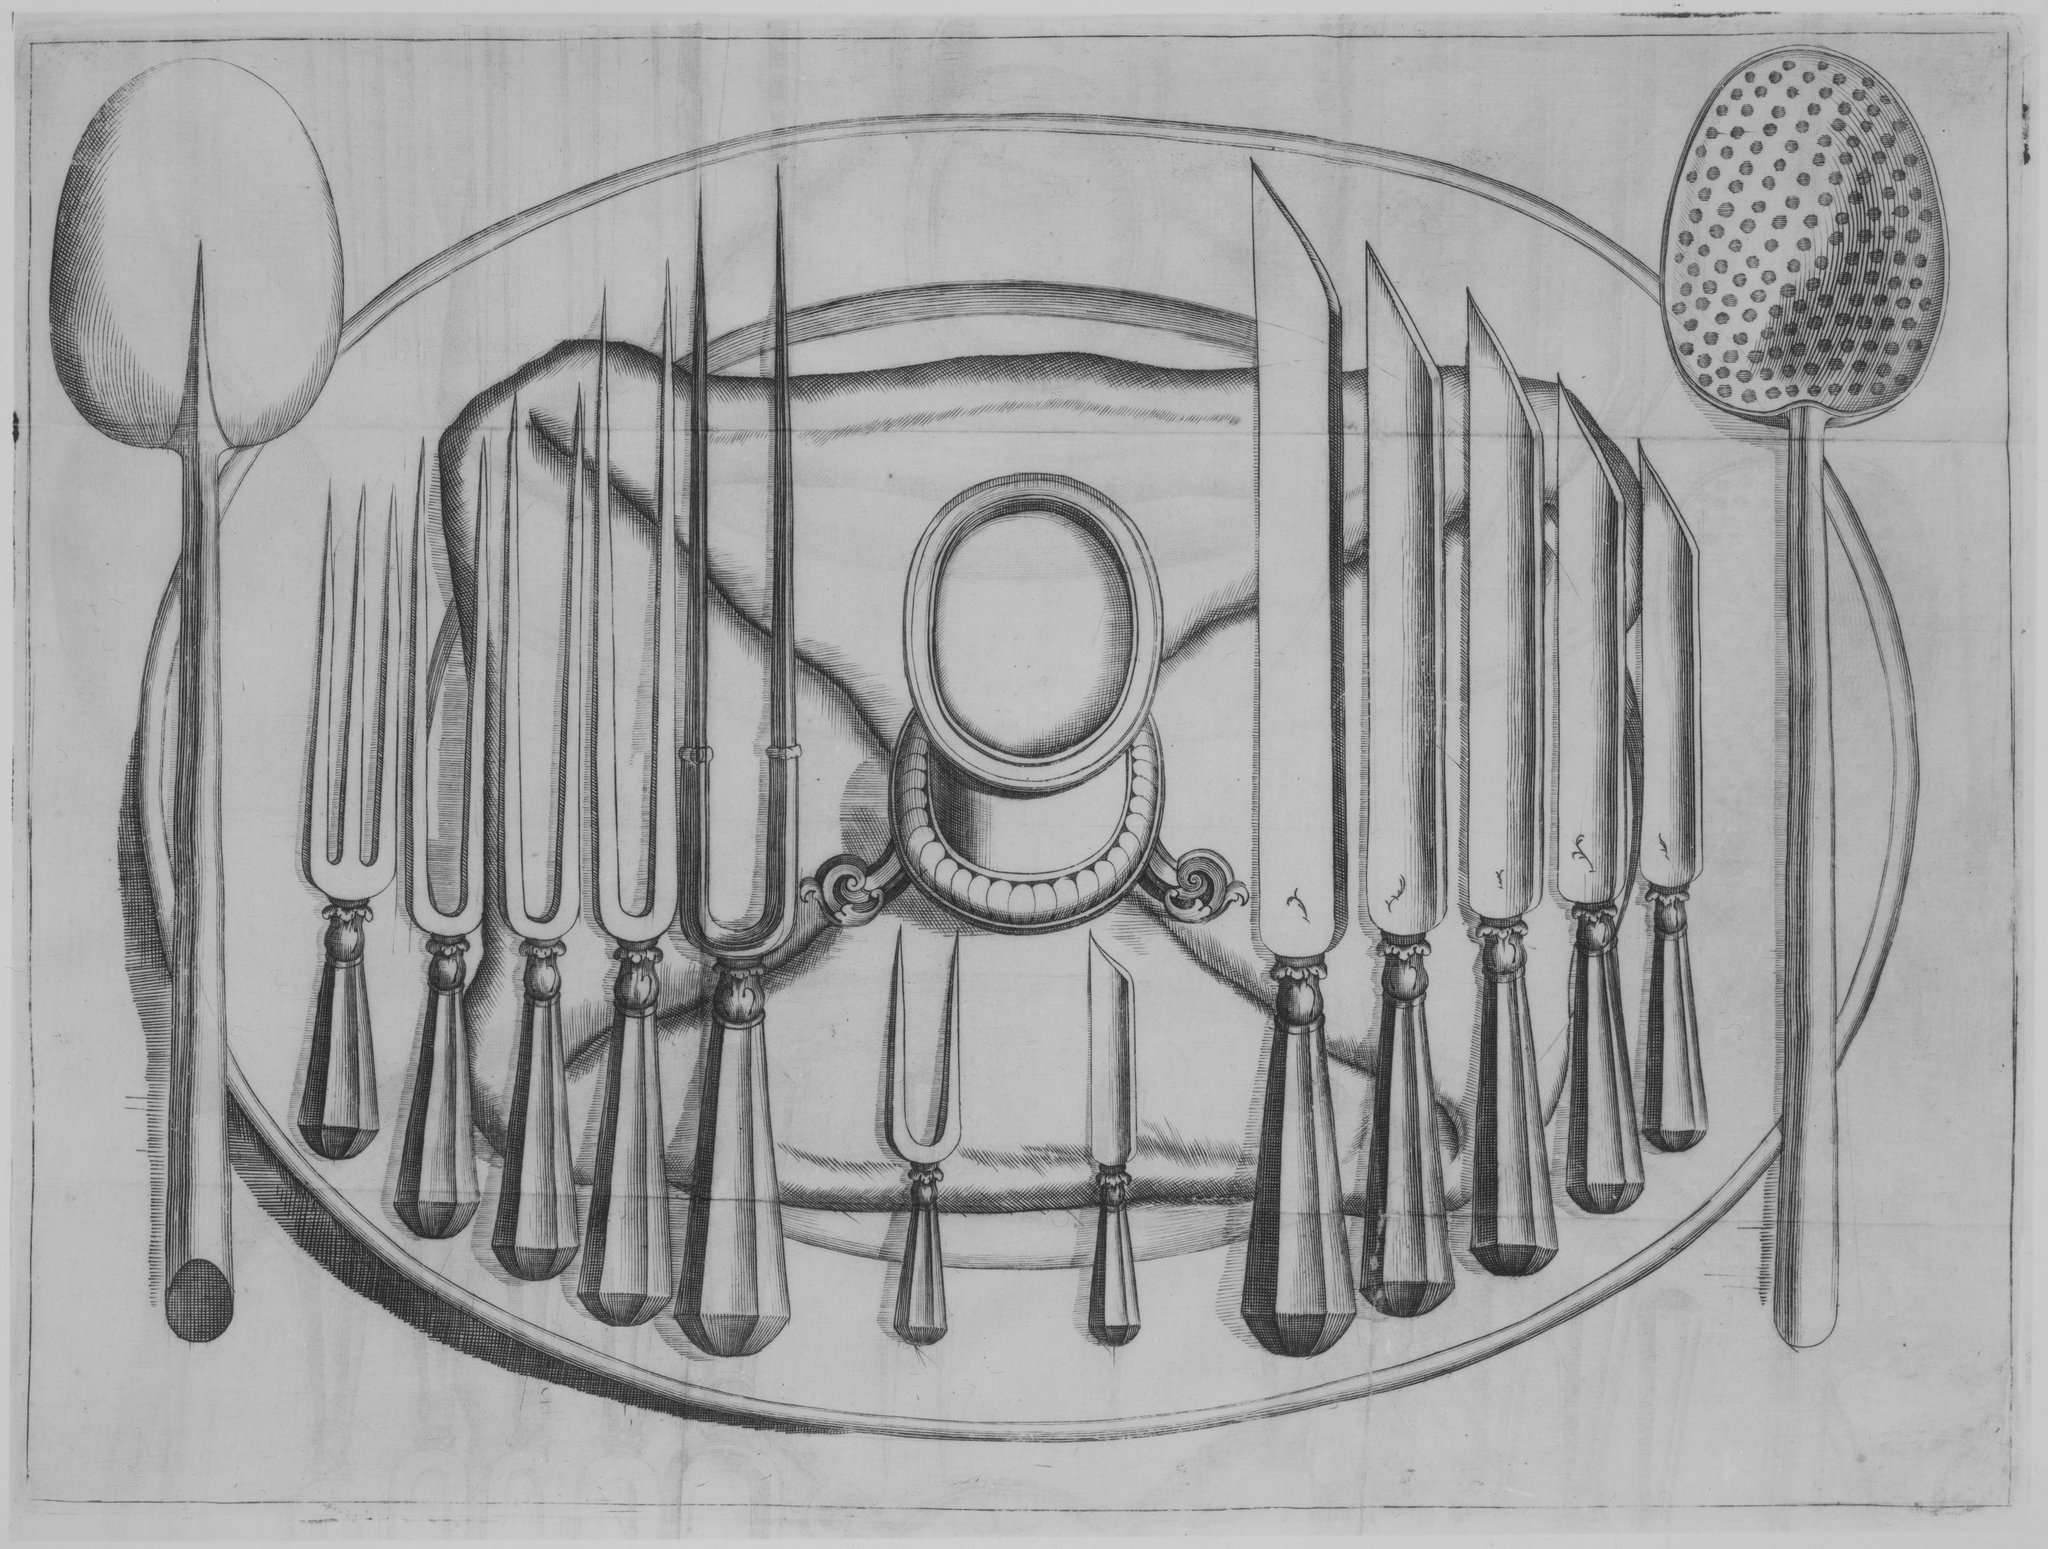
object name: book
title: Lo Scalco alla Moderna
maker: antonio latini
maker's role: author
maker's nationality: italian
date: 1694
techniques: printing, woodcut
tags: food